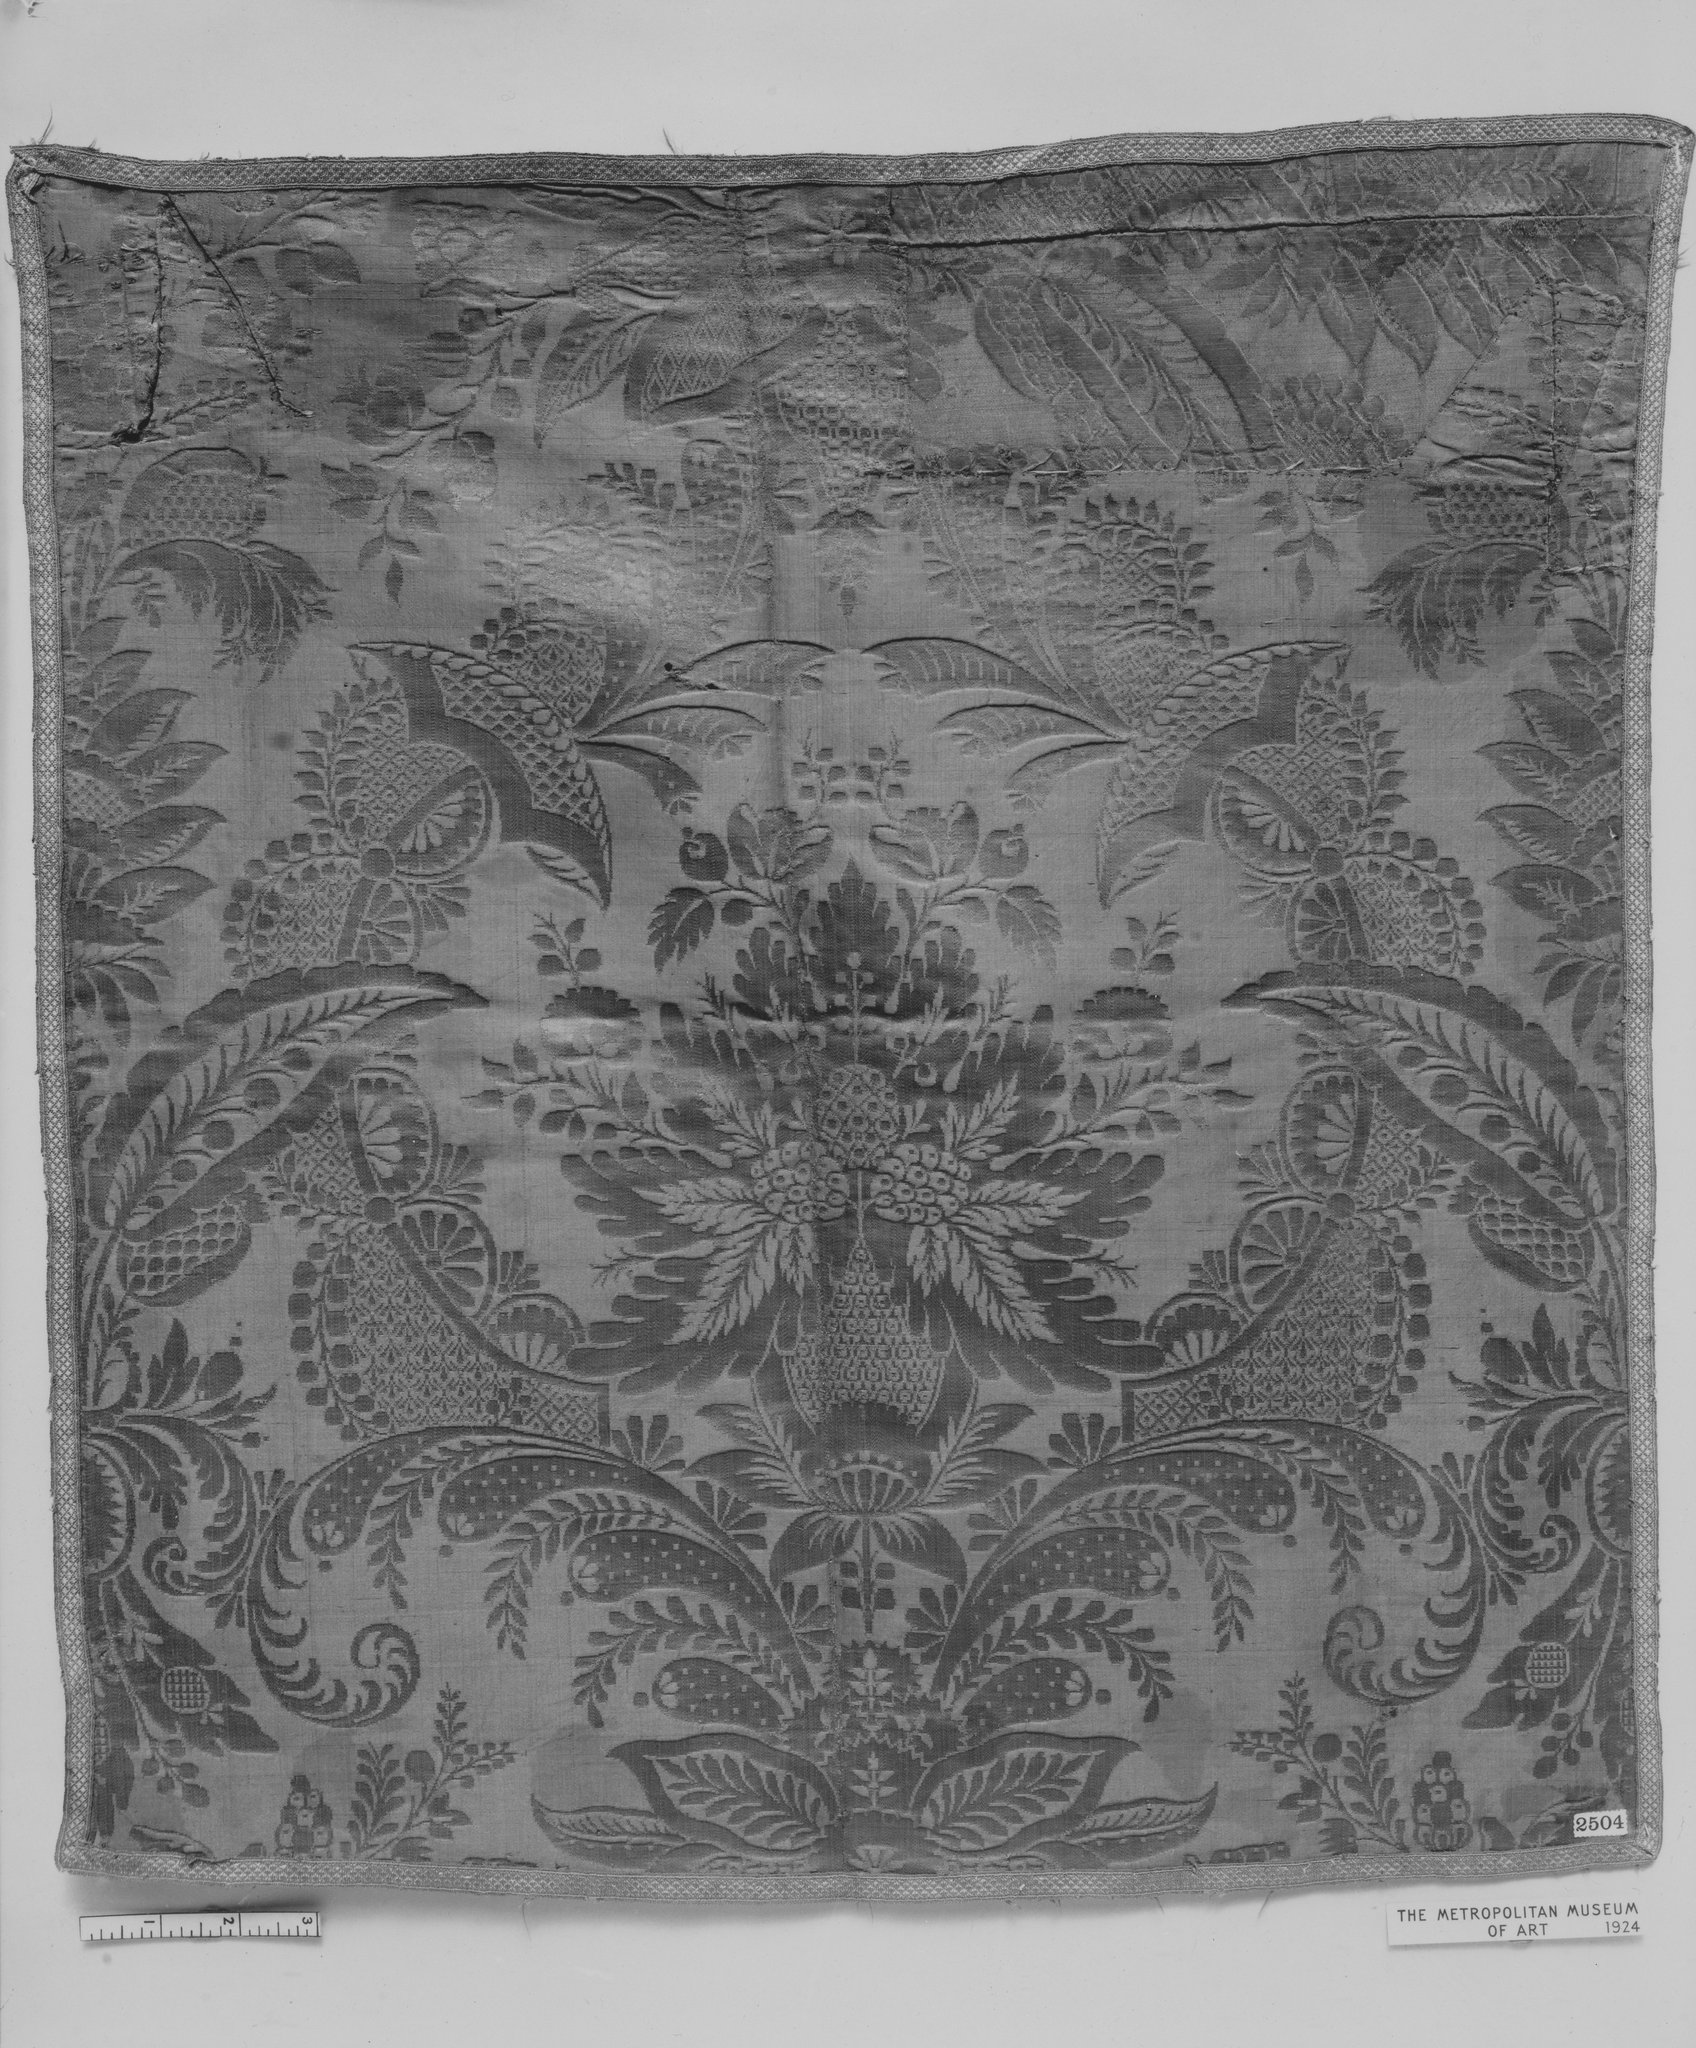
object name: piece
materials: silk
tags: leaves